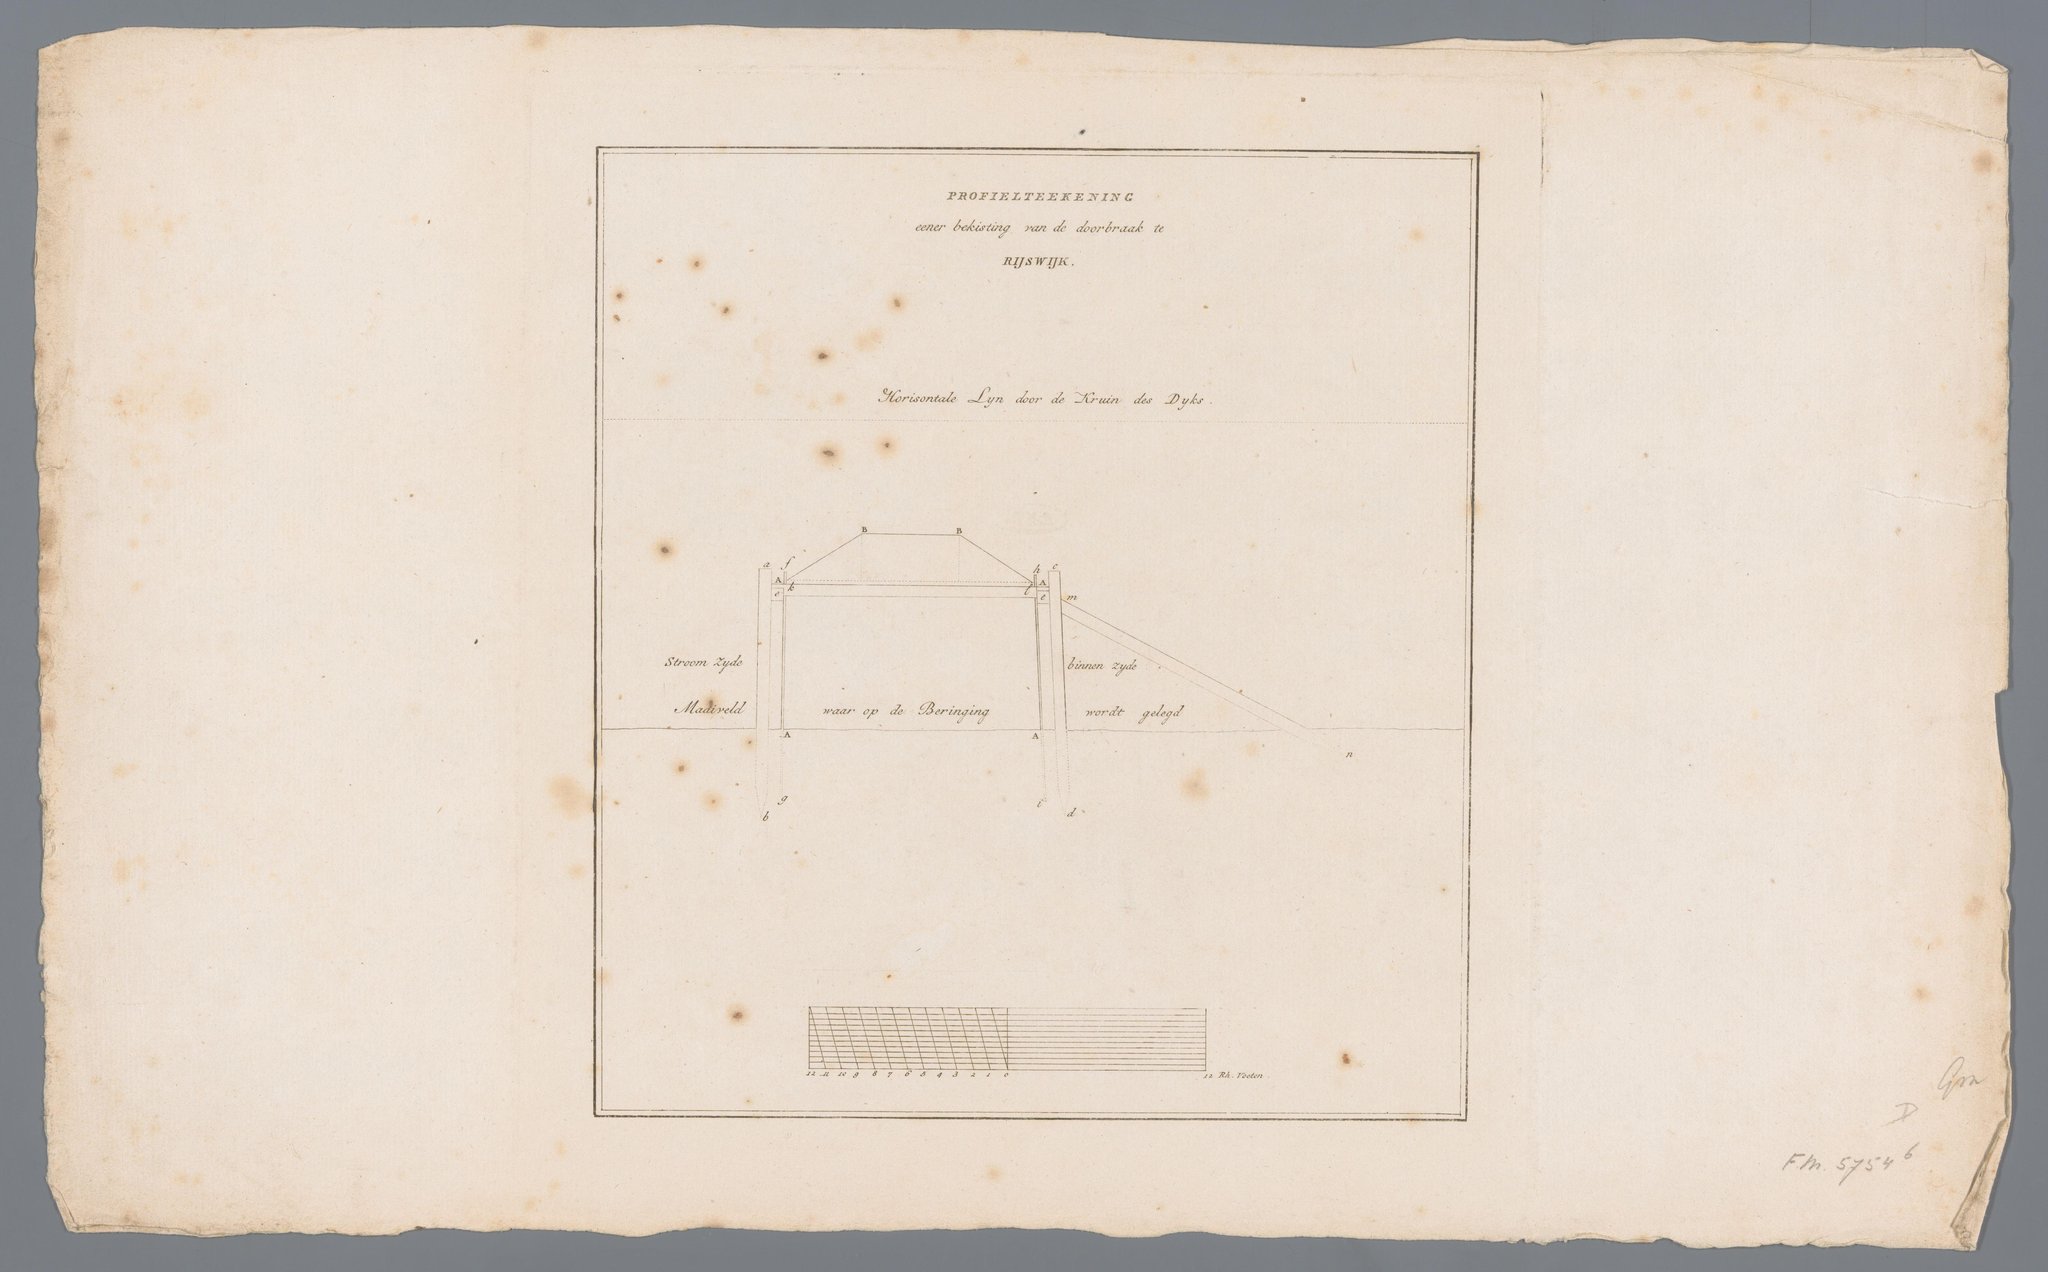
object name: book illustration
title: Technische tekening van dijkbekisting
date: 1809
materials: paper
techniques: etching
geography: amsterdam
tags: church (exterior)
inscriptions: collector's mark: Lugt 2228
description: Prent uit: Ewijk, H. Geschiedkundig verslag der dijkbreuken en overstroomingen, langs de rivieren in het Koningrijk Holland, voorgevallen in louwmaand MDCCCIX. 3 dln. Amsterdam: Johannes Allart en Jacobus Ruys, 1809.